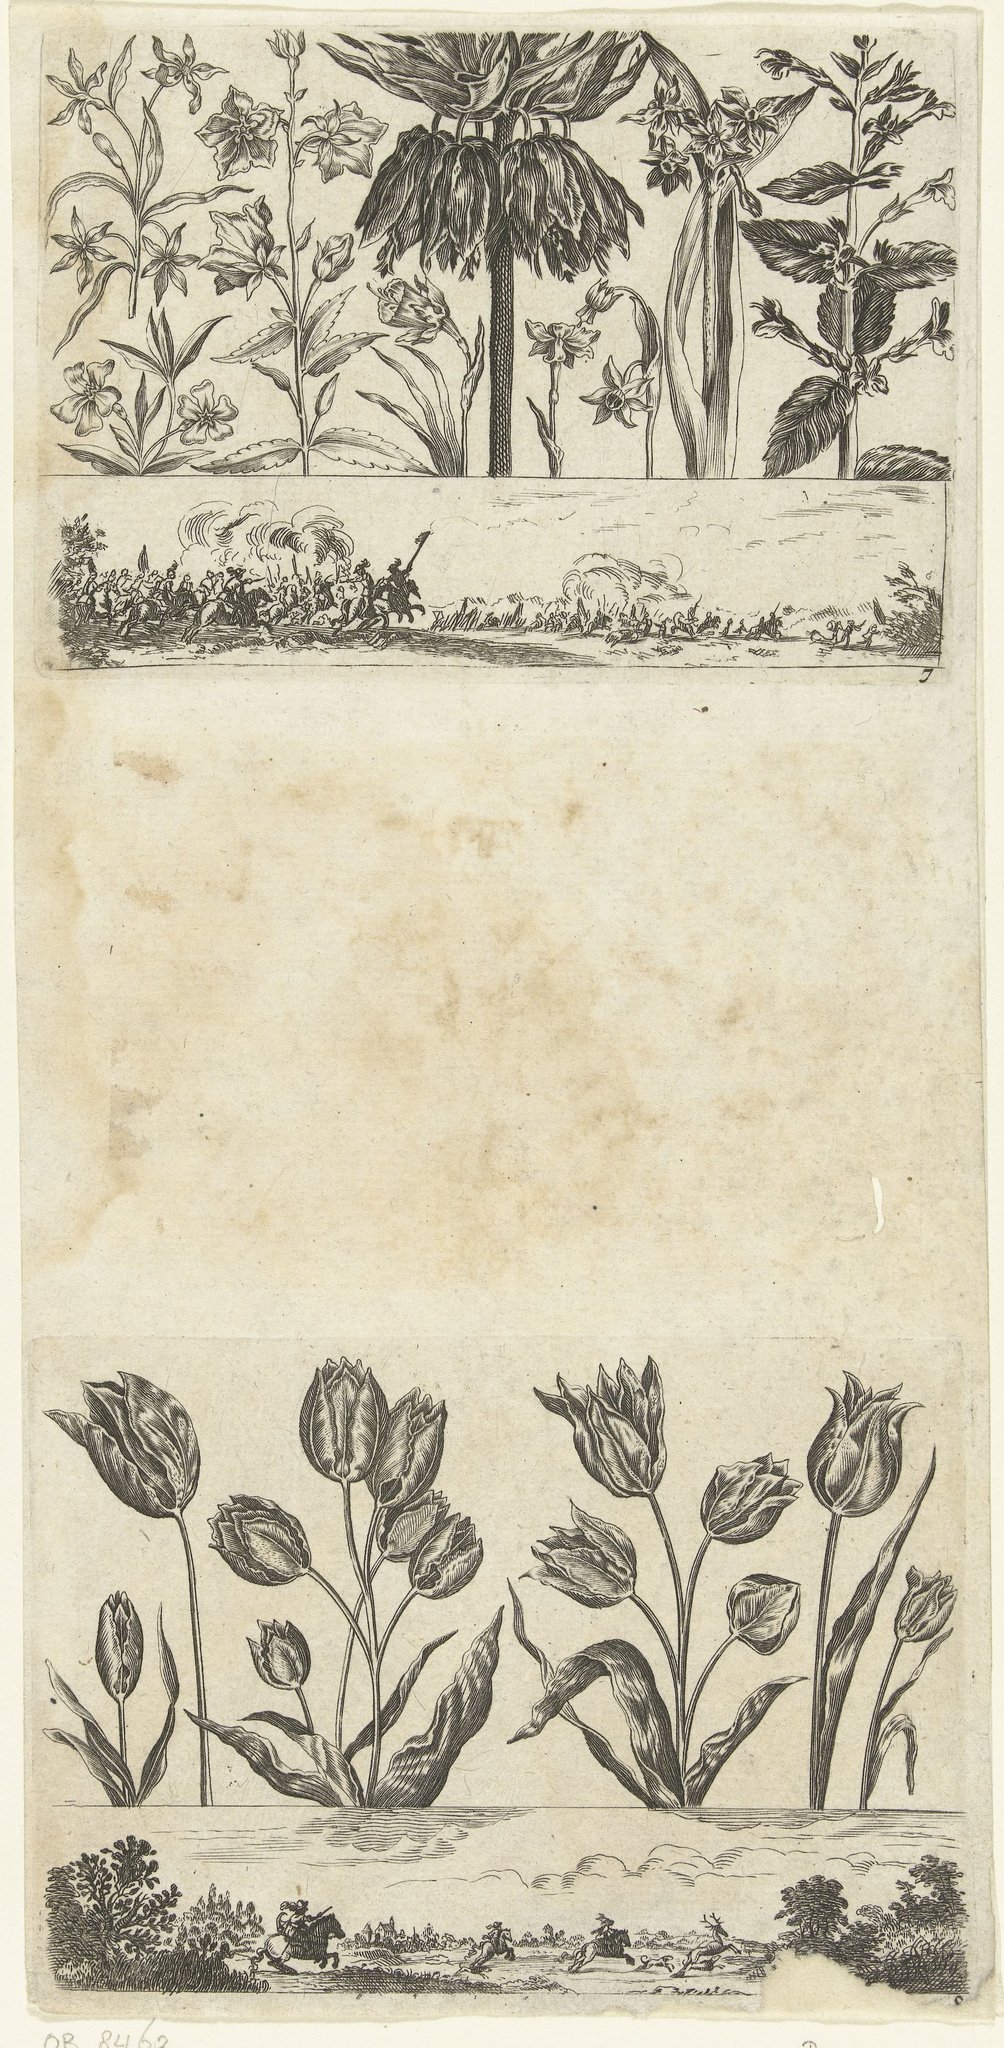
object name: print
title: Rij bloemen boven landschap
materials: paper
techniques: etching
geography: netherlands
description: Blad 8 uit serie van 7 bladen, genummerd 3-10, één blad heeft geen nummer. Tweede editie.